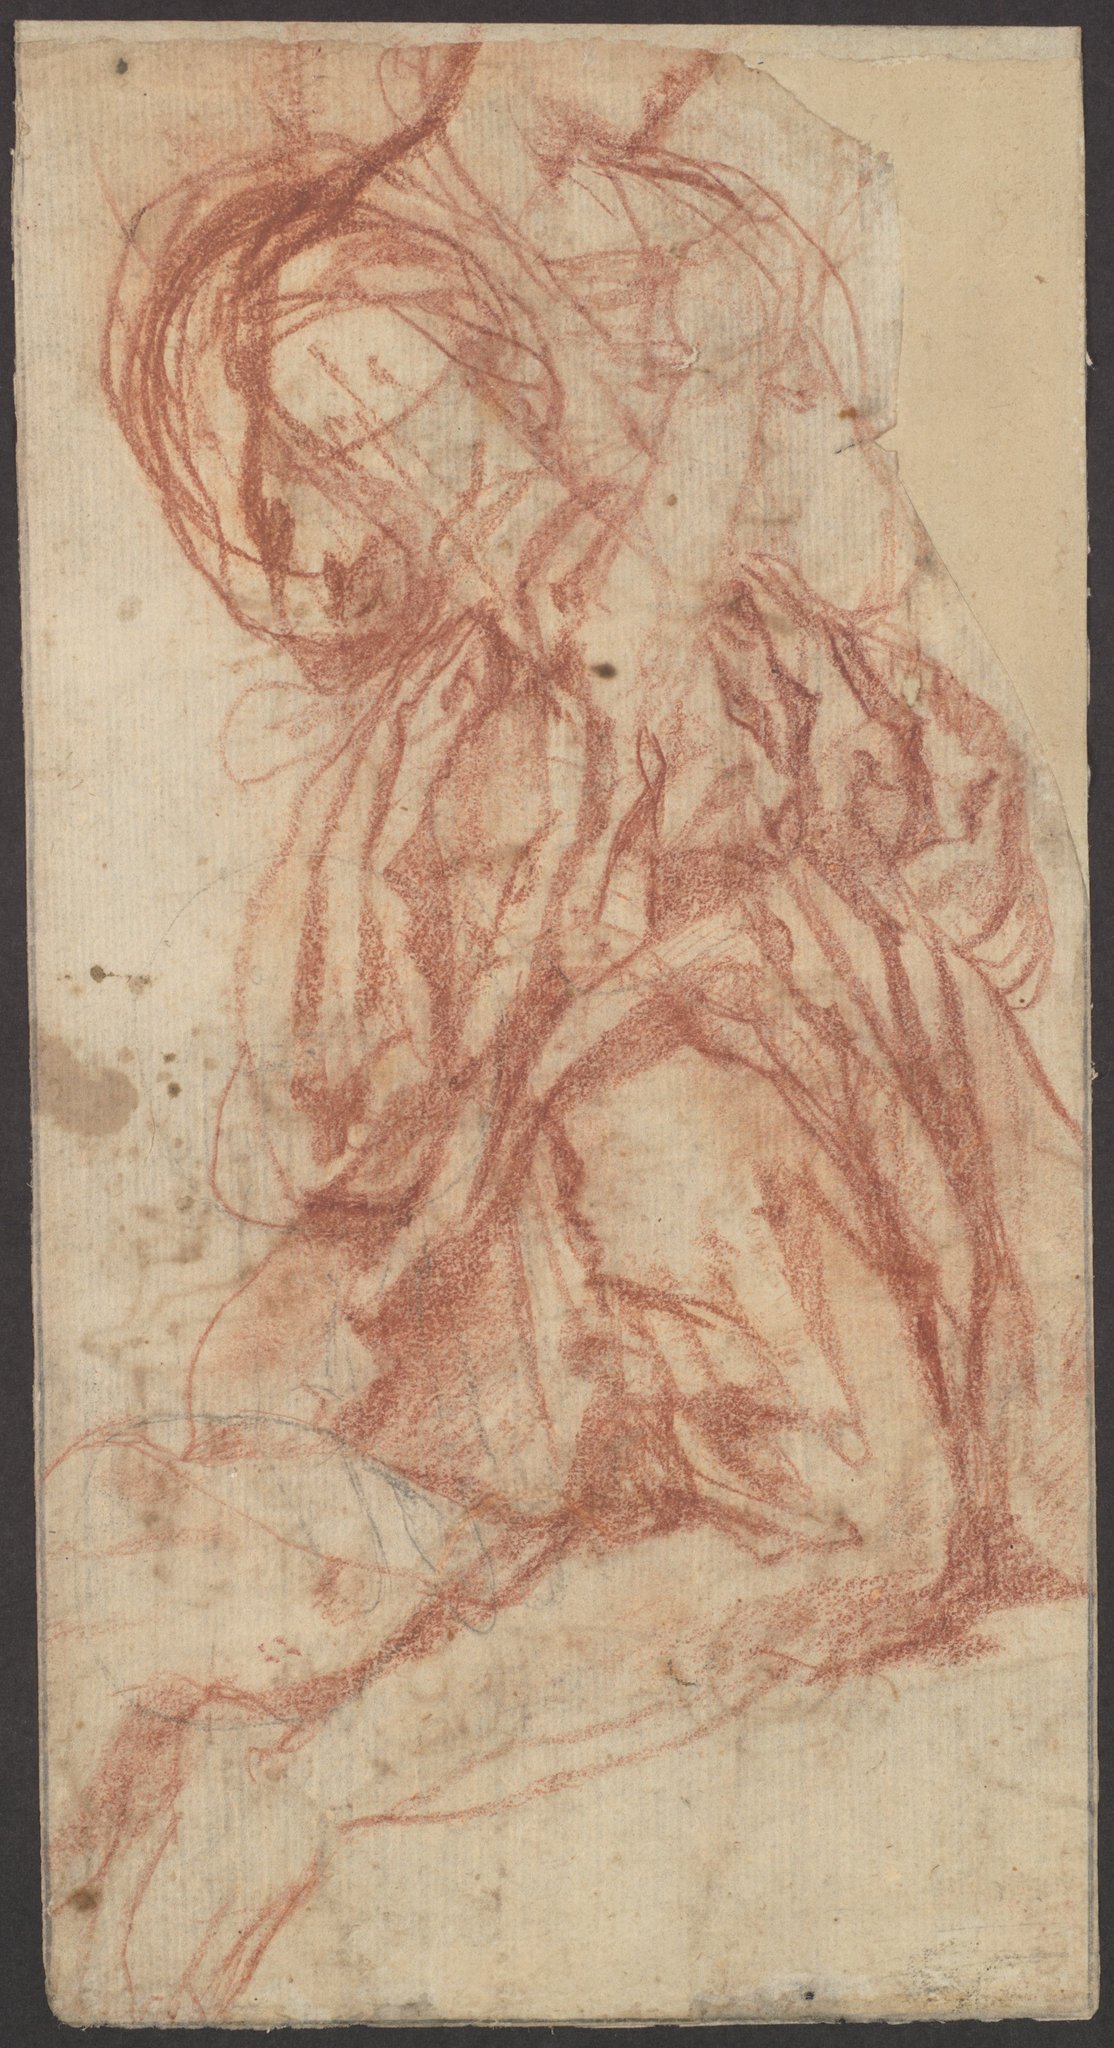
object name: drawing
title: Study of a Kneeling Figure (recto); Design for a Festival Chariot (verso)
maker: anonymous, italian, florentine, 16th century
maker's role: artist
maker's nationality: italian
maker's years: 1500-1600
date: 1530-1540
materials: chalk, ink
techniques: pen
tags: human figures,chariots